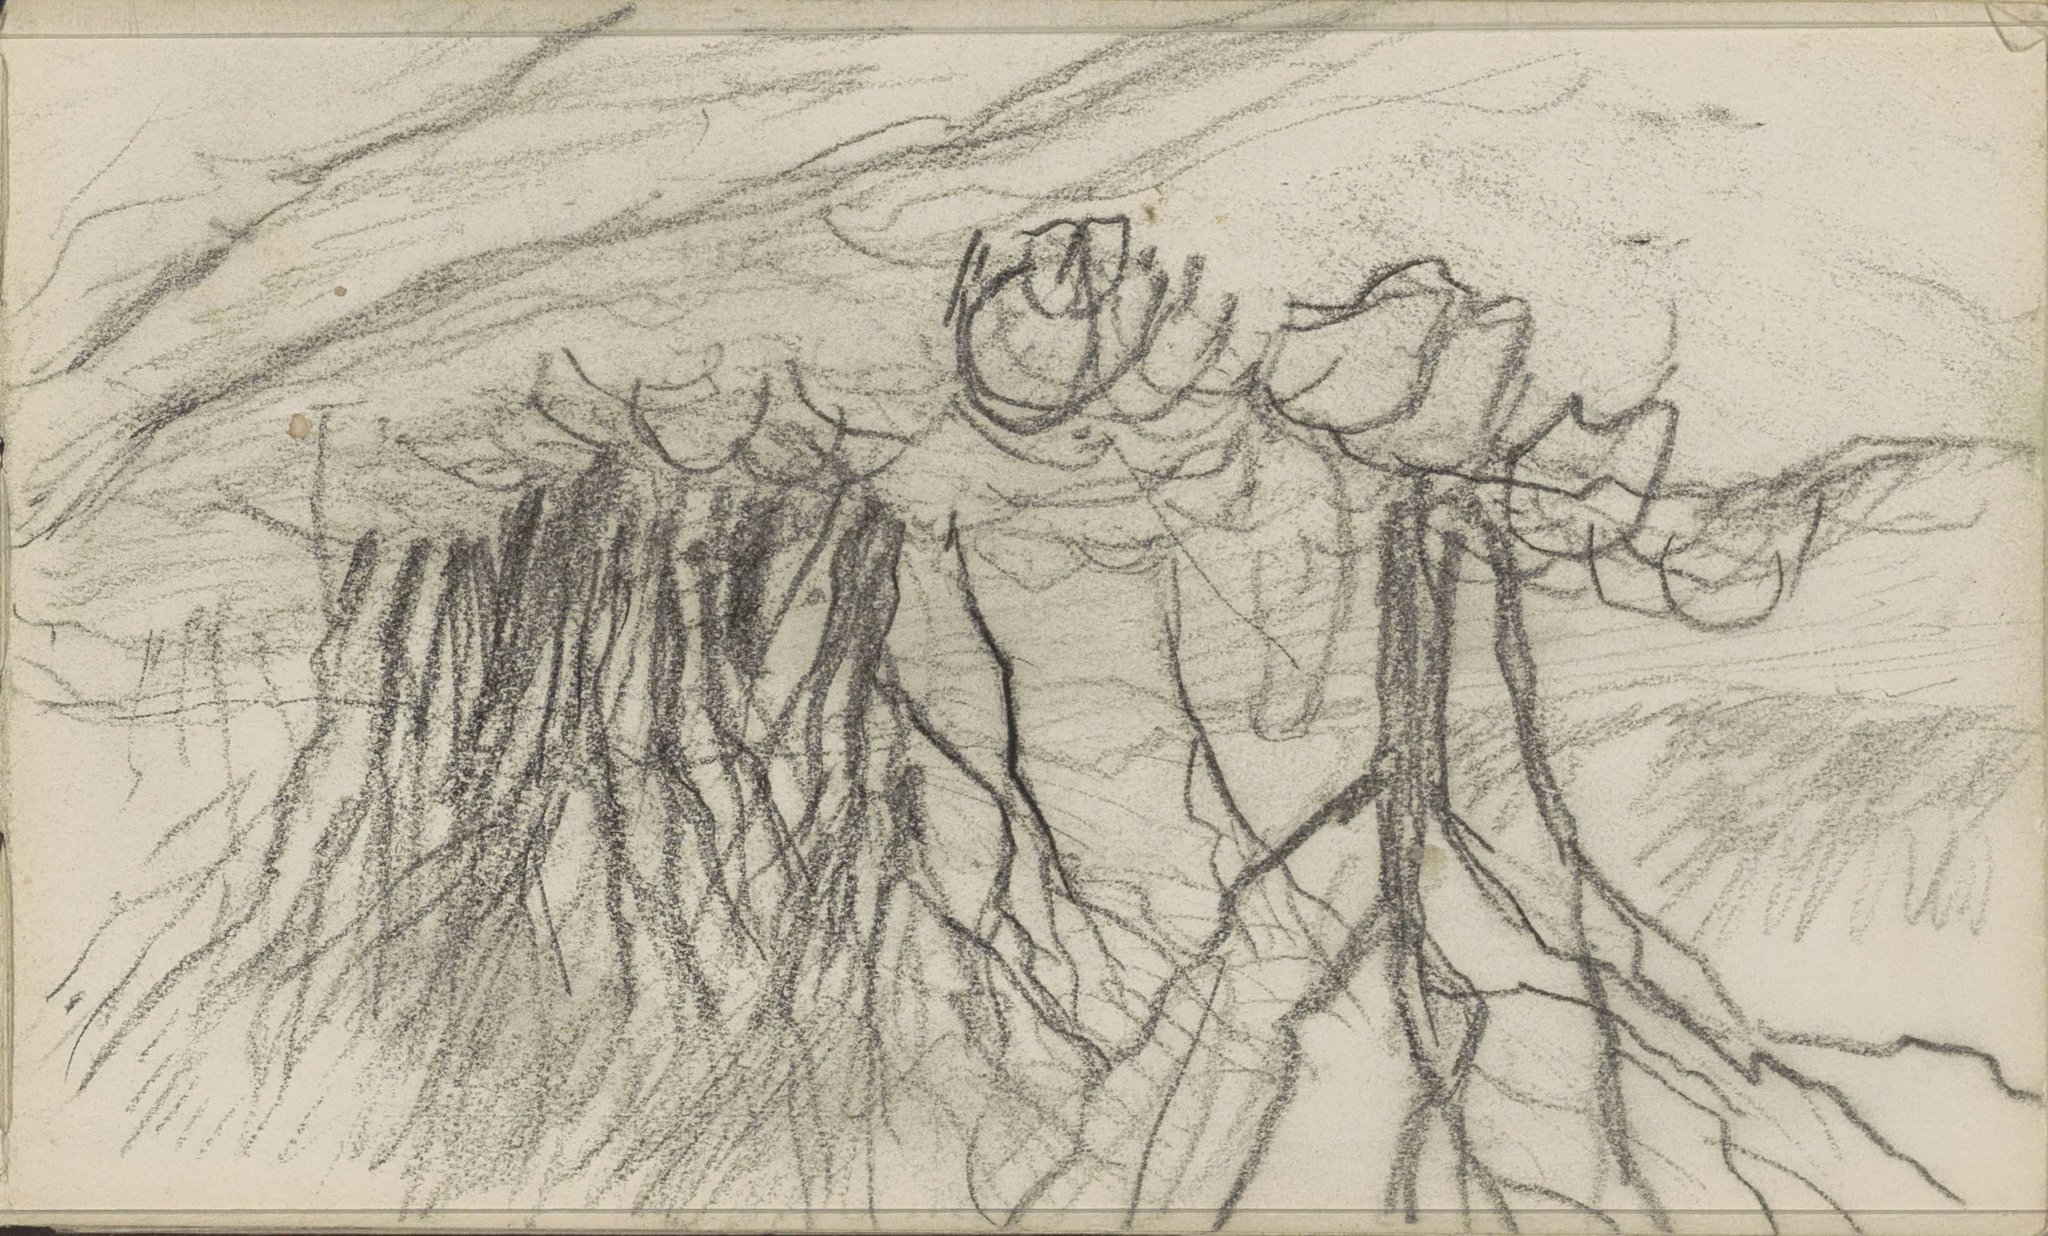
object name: sketchbook leaf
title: Kudde schapen bij een groep bomen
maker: anton mauve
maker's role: draughtsman, painter, print maker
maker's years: 1838-1888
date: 1848-1888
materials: chalk, paper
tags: sheep, herd, flock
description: Blad 14 recto uit een schetsboek met 33 bladen.